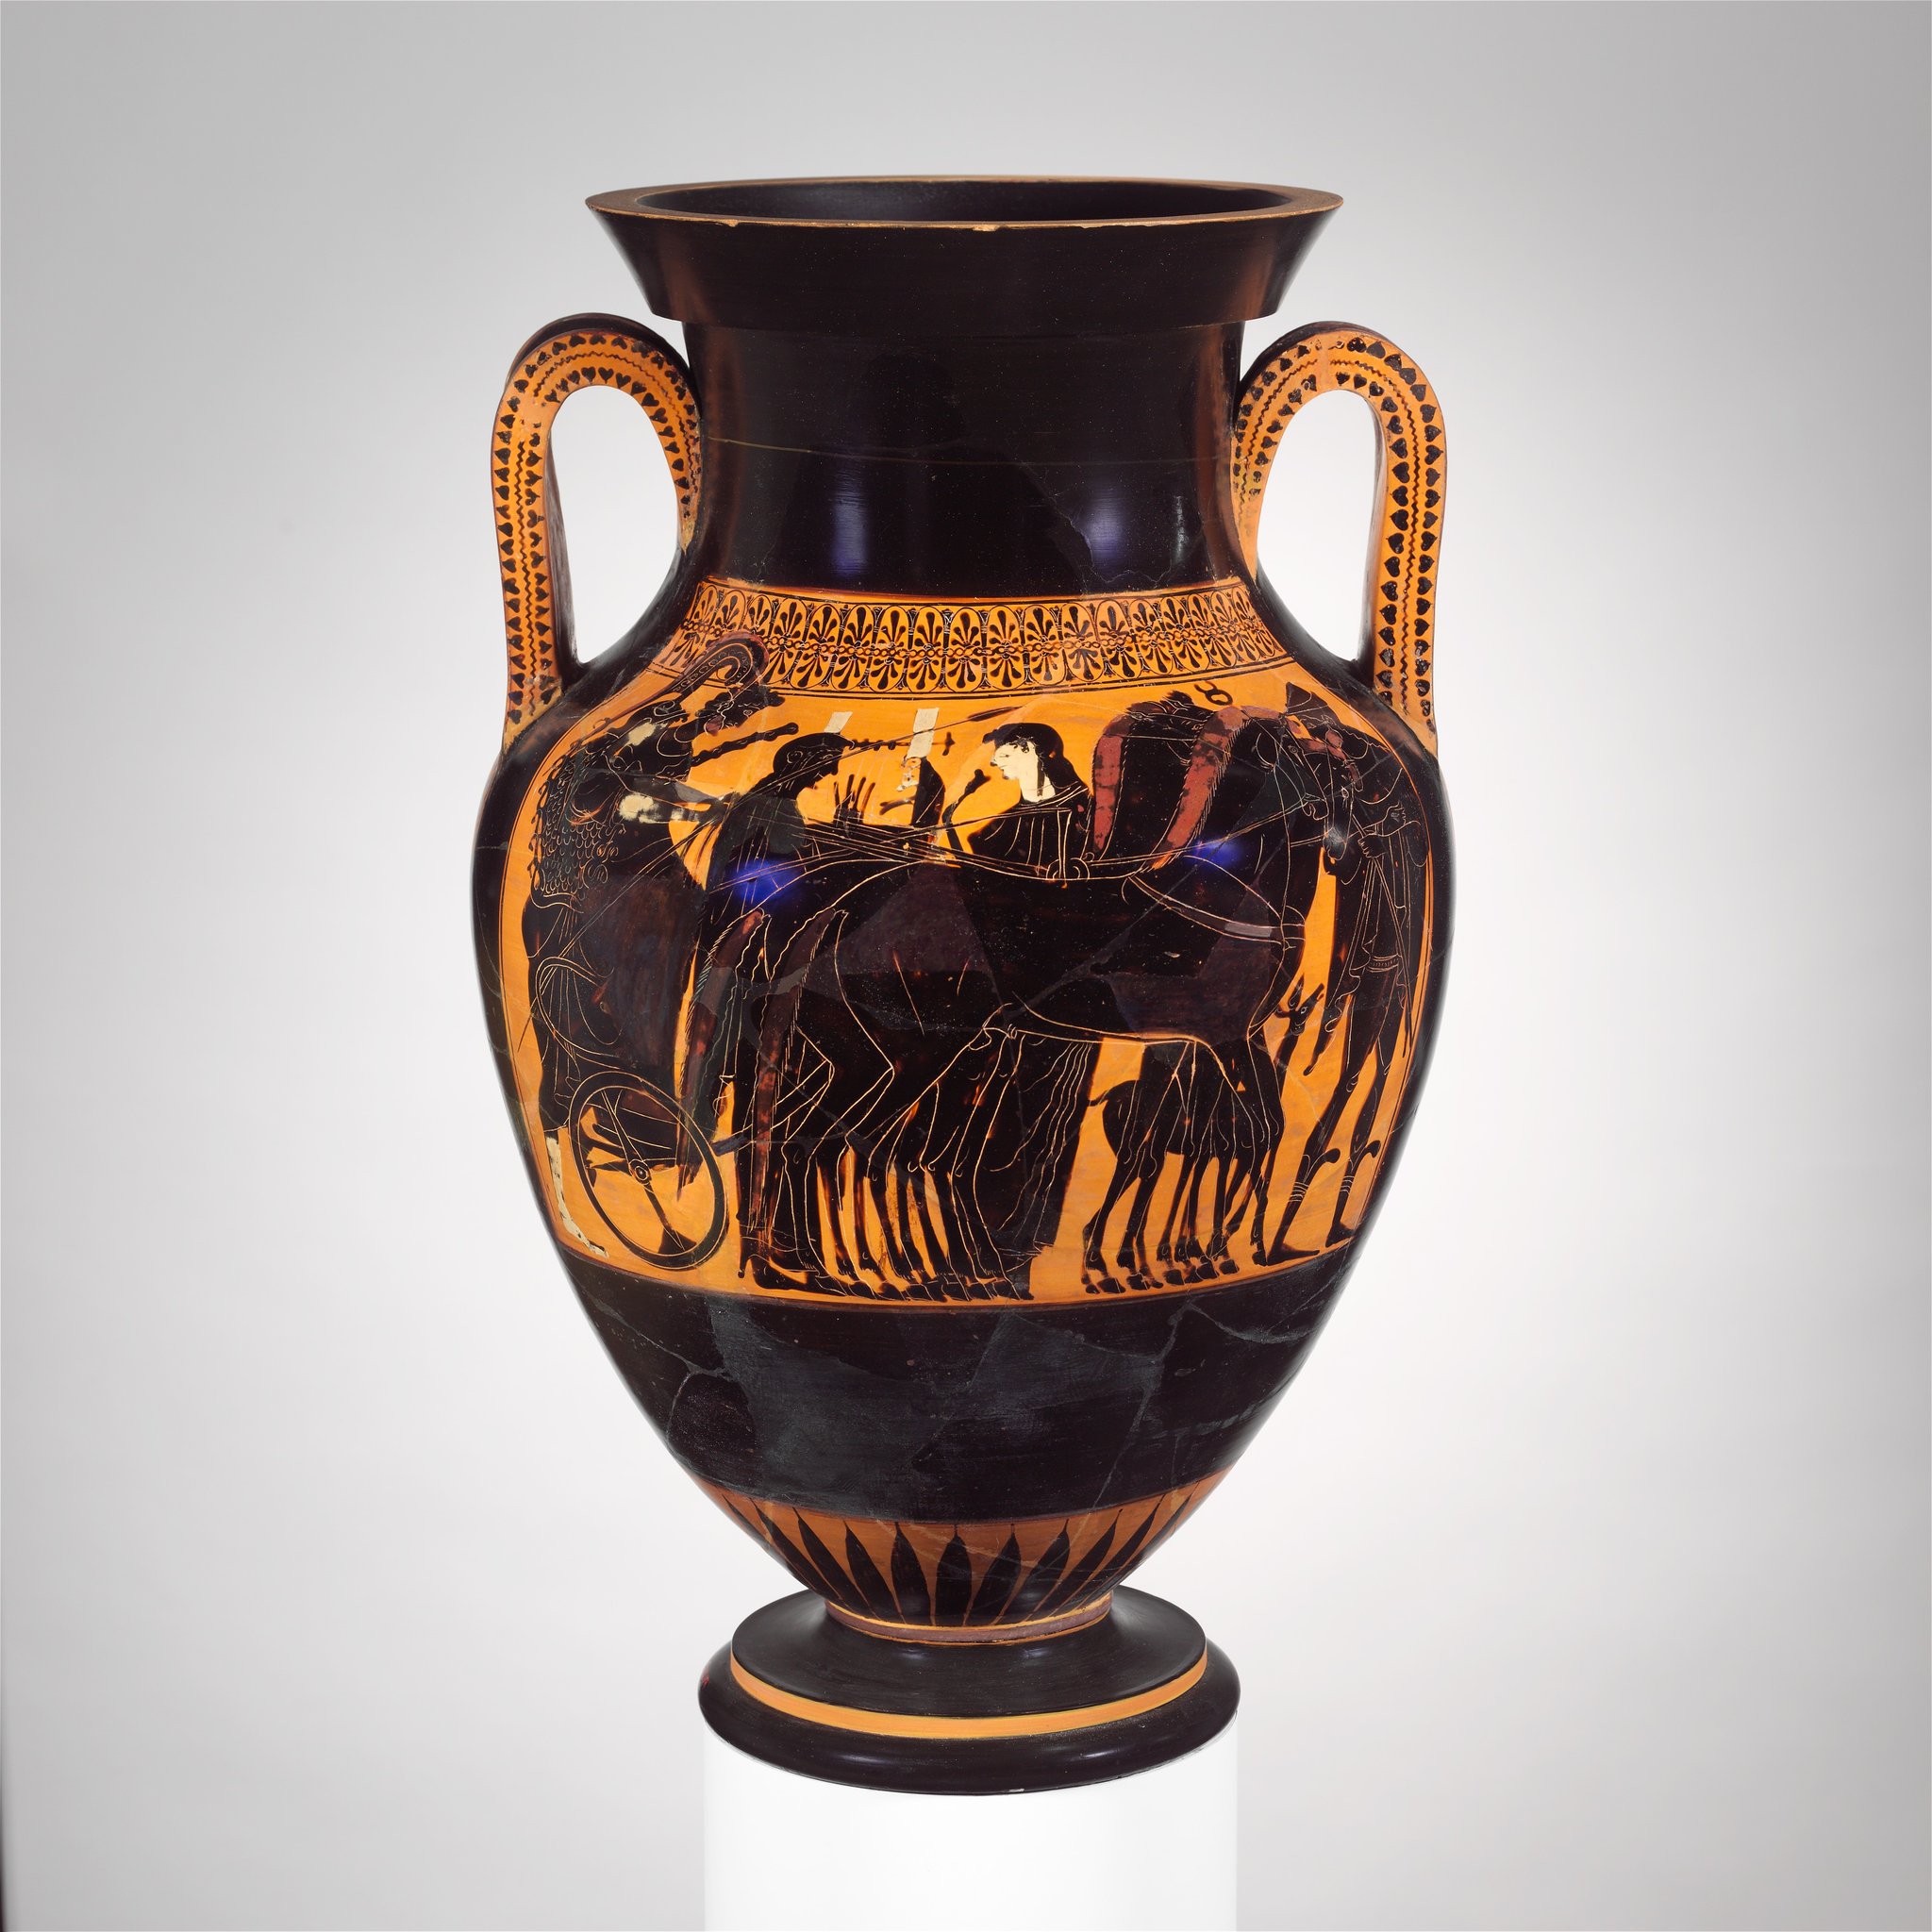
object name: amphora, type a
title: Terracotta amphora (jar)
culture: greek, attic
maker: antimenes painter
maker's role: artist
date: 510 BCE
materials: terracotta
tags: apollo,artemis,athena,dionysus,dogs,horses,chariots,herakles